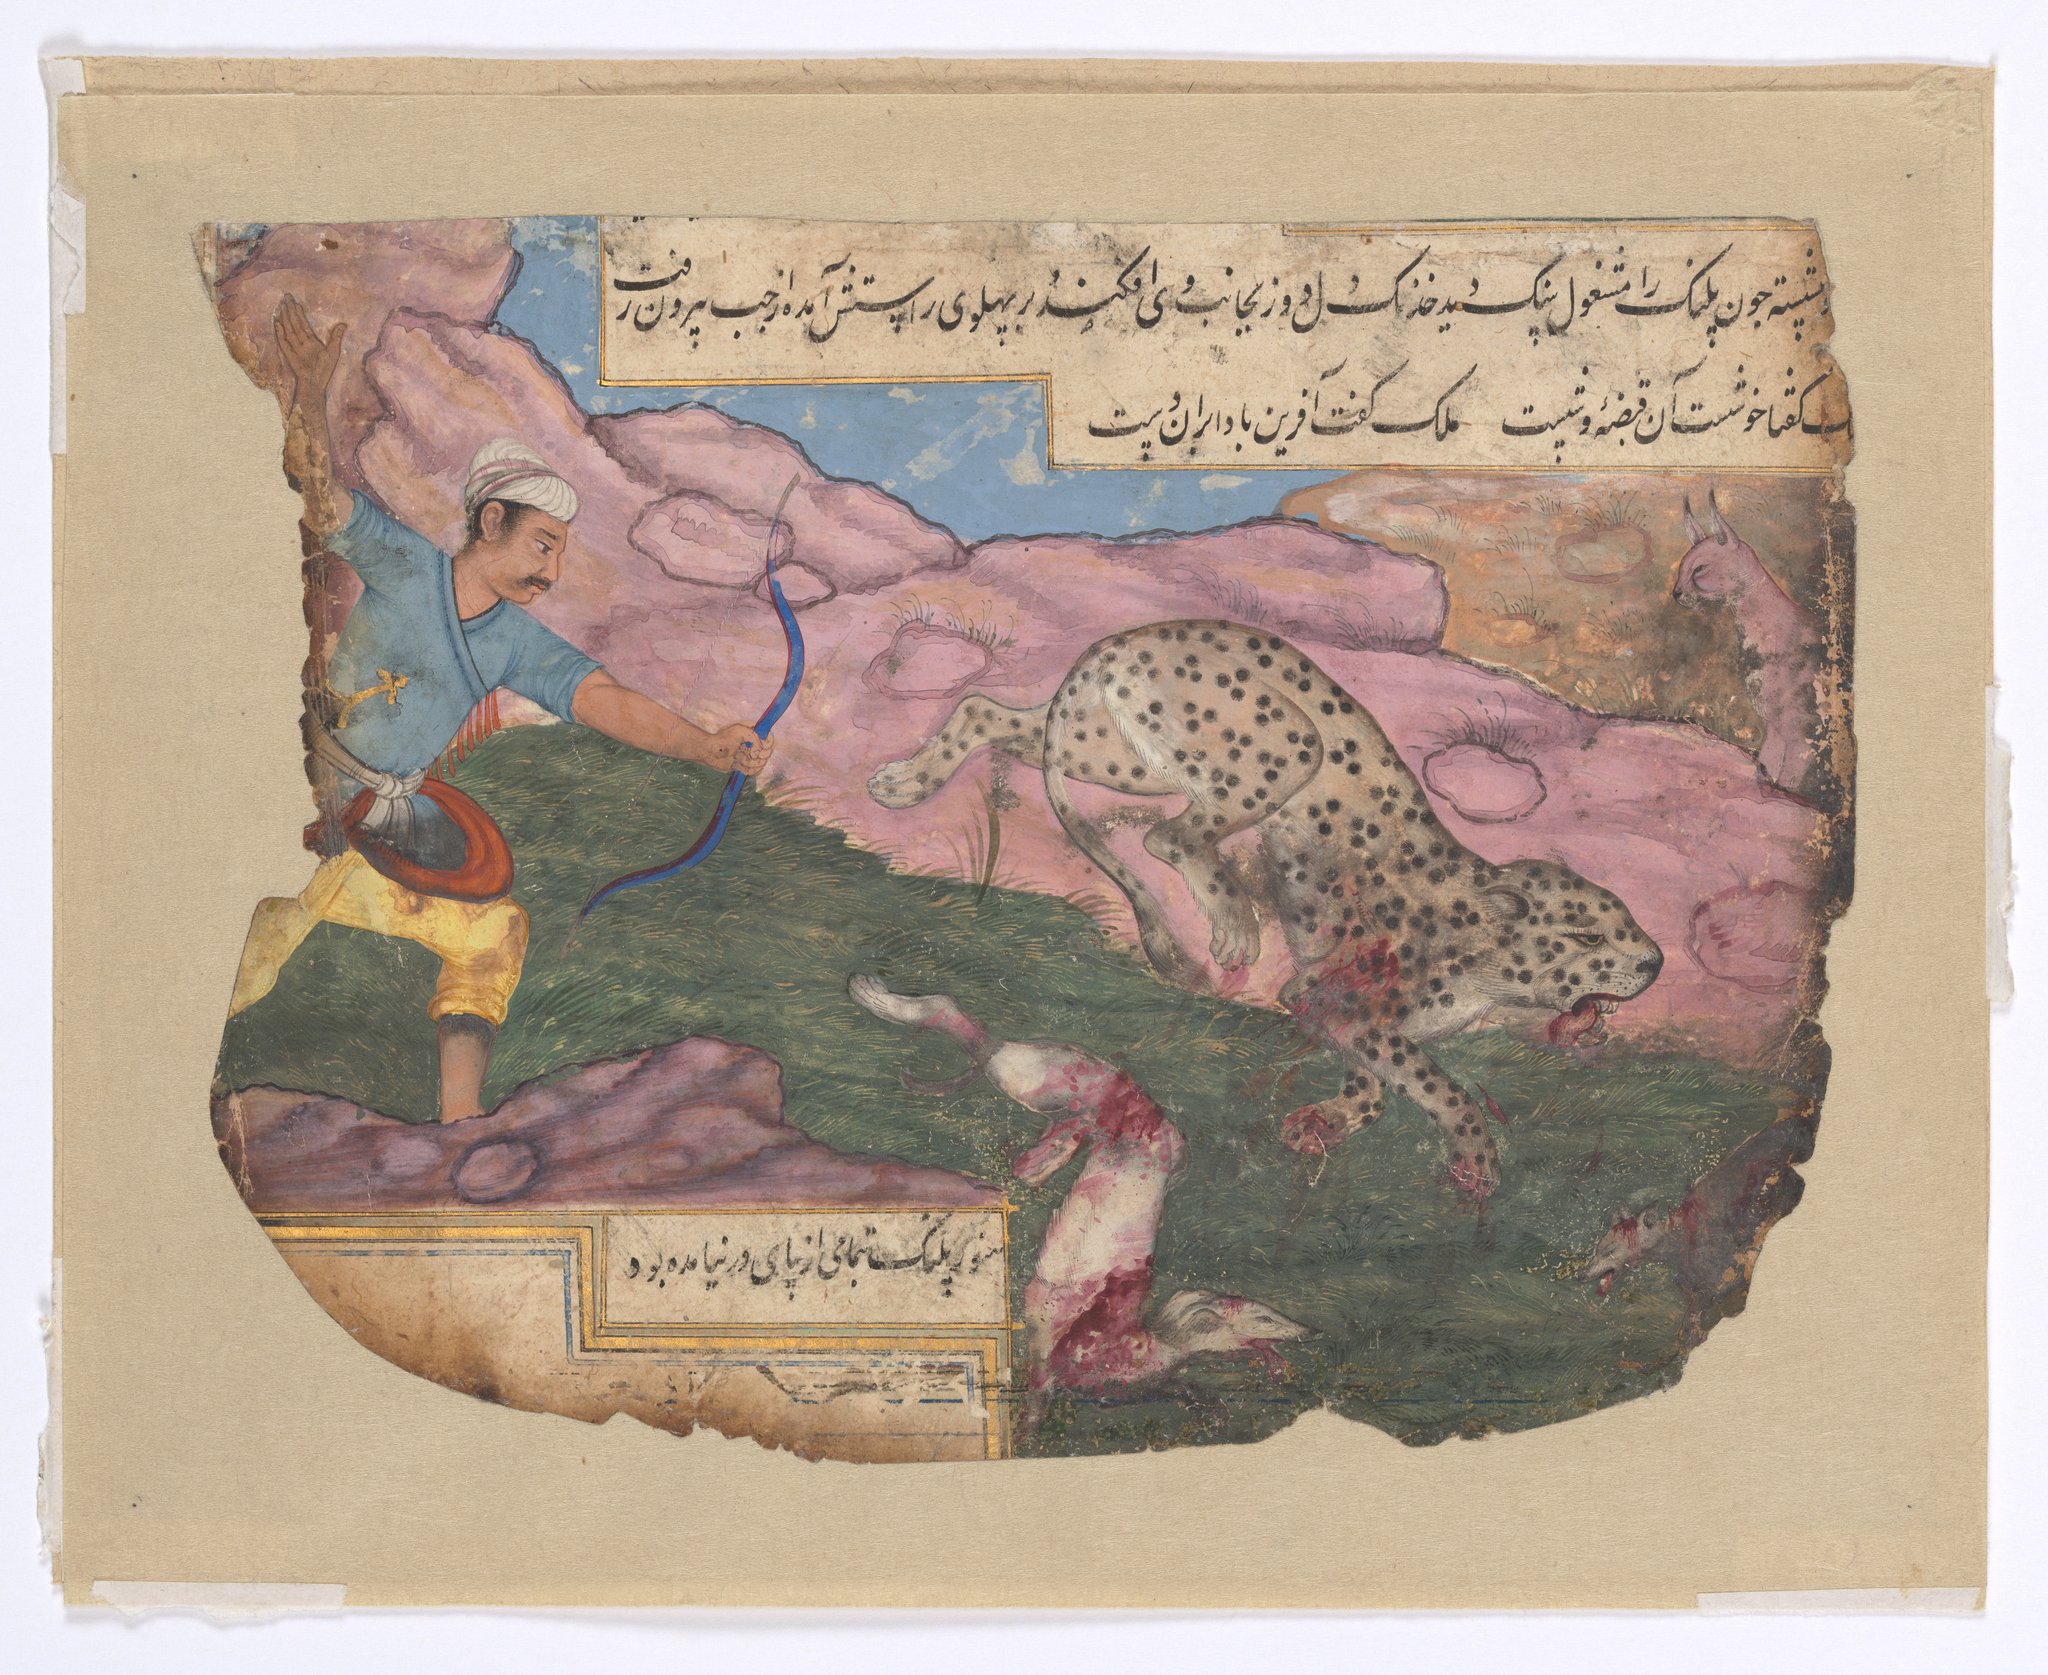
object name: folio from an illustrated manuscript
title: A Hunter Shoots a Leopard; Illustration to the Anwar-i Suhaili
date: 1570-1575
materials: gold, paper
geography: india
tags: bow and arrow,hunting,leopards